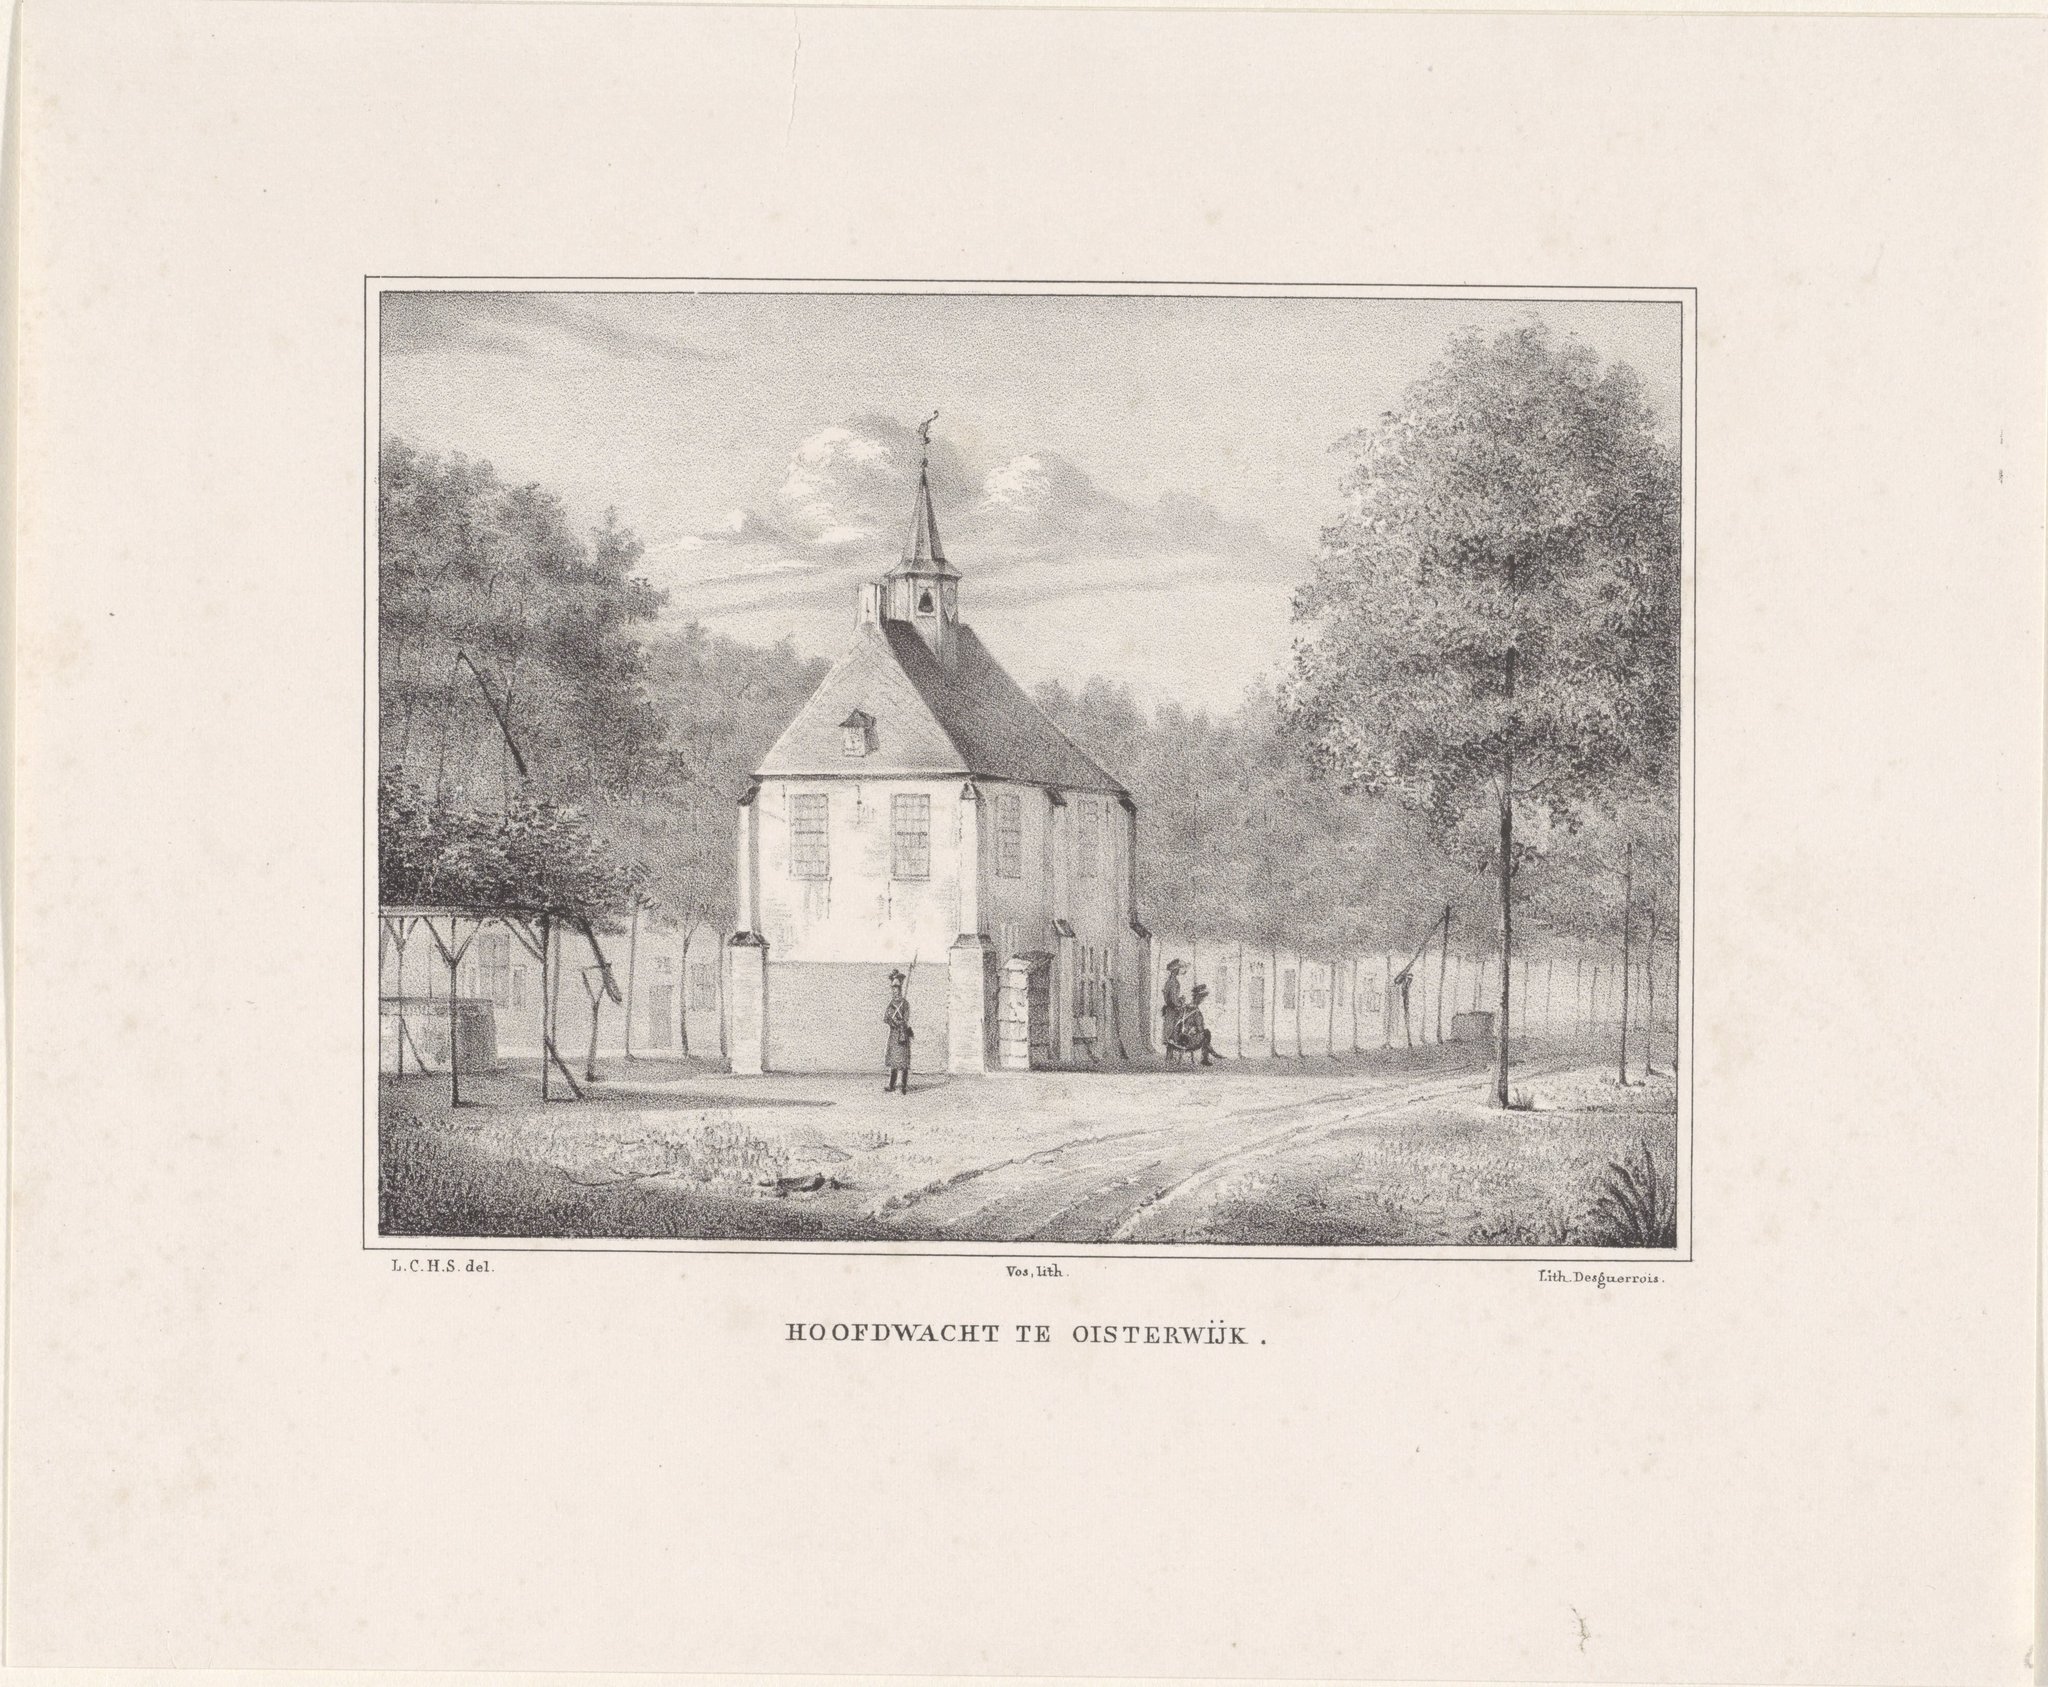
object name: print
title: Vijf wachthuizen der Nederlandse schutterij in Noord-Brabant in 1830-1831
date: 1831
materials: paper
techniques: lithograph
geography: netherlands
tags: shelter ~ military service, guard duty, keeping sentry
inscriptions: collector's mark: Lugt 2228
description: Gezicht op het hoofdwacht van de vrijwillige schutterij in het gebouw van de Protestantse kerk te Oisterwijk. Onderdeel van een serie van vijf voorstellingen van de wachthuizen van de Nederlandse schutterij in Noord-Brabant in 1830-1831.